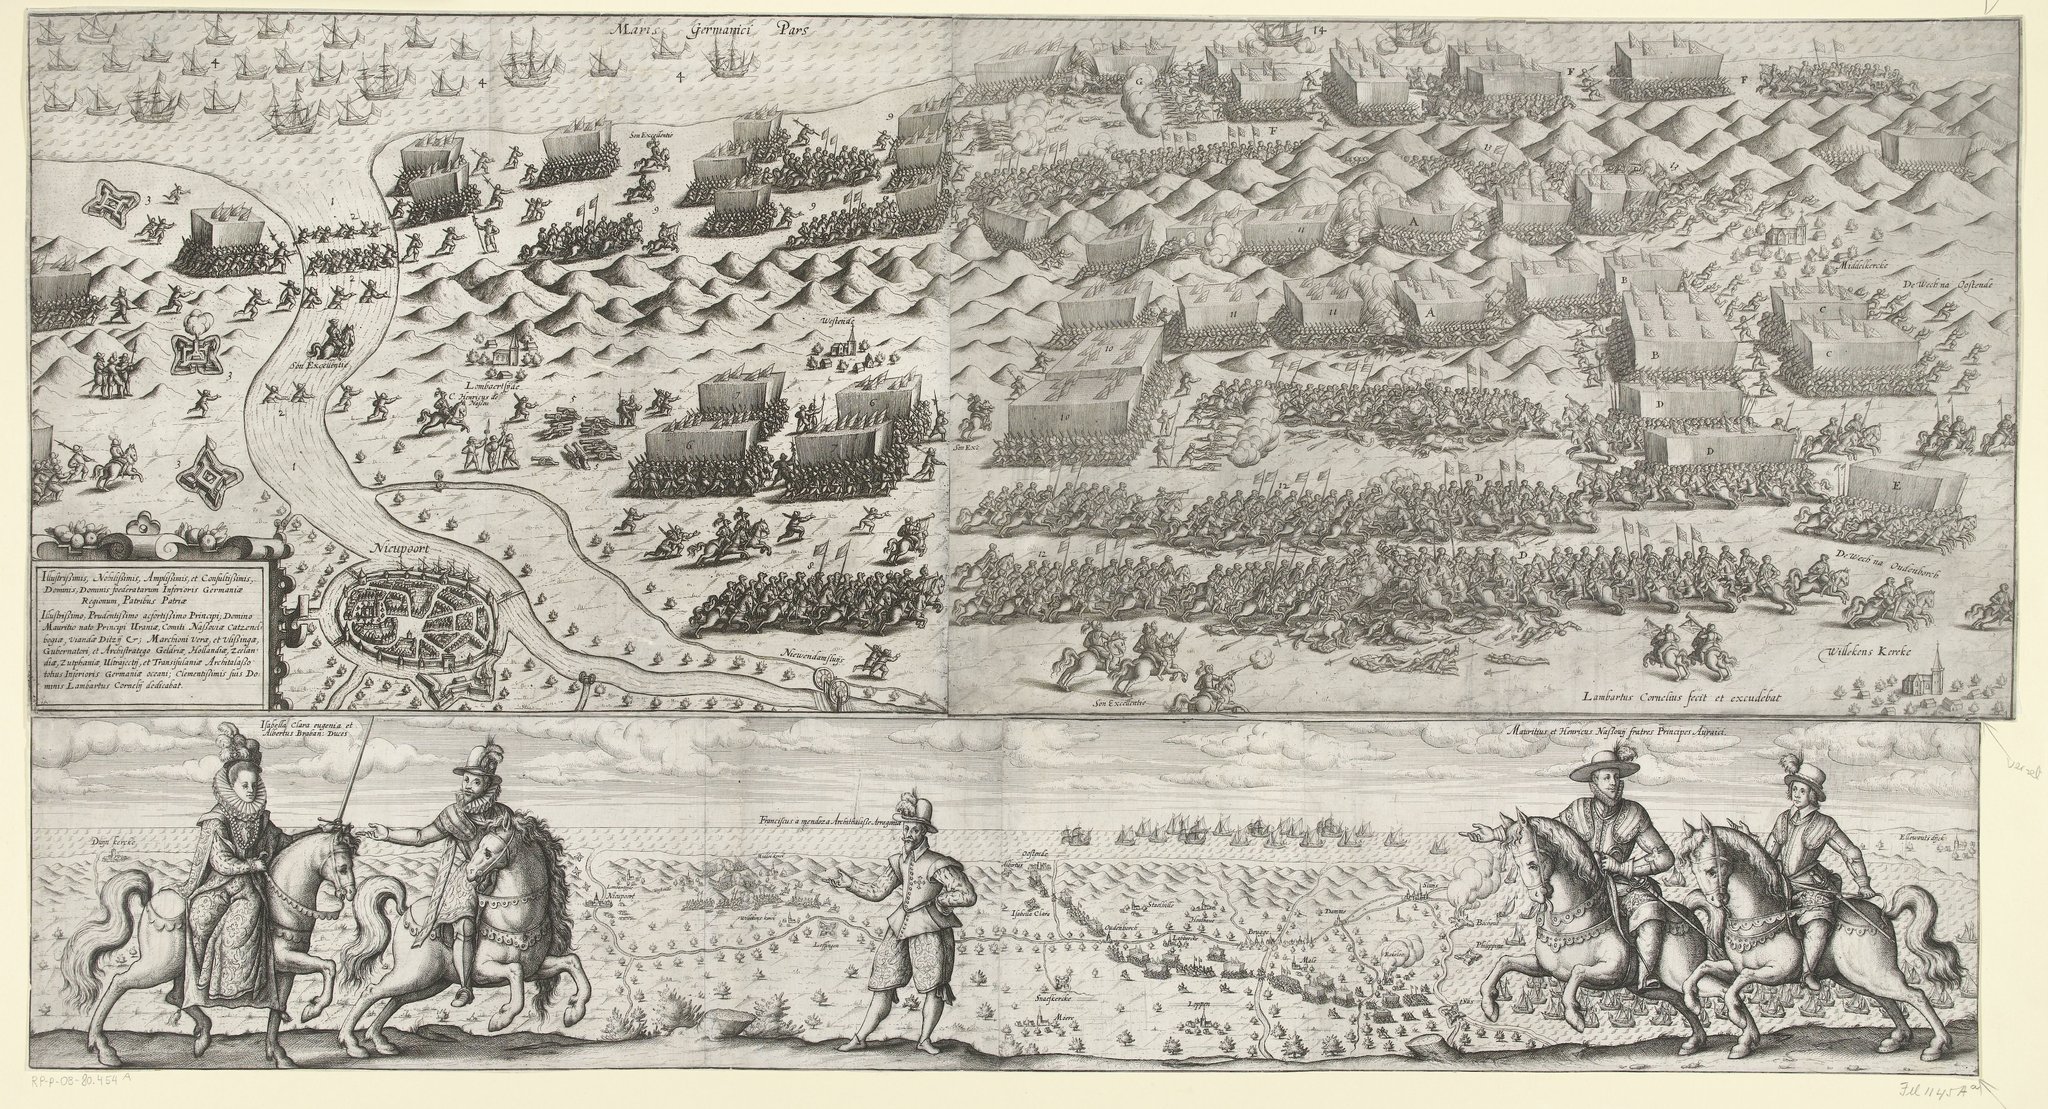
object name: print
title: De slag bij Nieuwpoort gecombineerd met portretten van Albrecht en Isabella met Mendoza en Maurits en Frederik Hendrik te paard voor het slagveld, 1600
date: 1600-1601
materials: paper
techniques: engraving, etching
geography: northern netherlands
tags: delft, frederick henry (prince of orange), the hague, maurice (prince of orange), infante van spanje isabella clara eugenia, brussels, albrecht aartshertog van oostenrijk, troop movements, transportation (+ sailing-ships), historical persons - bb - woman, historical persons, battle of nieuwpoort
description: De slag bij Nieuwpoort, 2 juli 1600. Grote voorstelling op twee bladen, links het Staatse leger onder Maurits, rechts de Spaanse troepen onder Albrecht. Linksonder een cartouche met de opdracht in het Latijn. Hieronder vastgeplakt links Albrecht en Isabella te paard met de Spaanse legeraanvoerder Mendoza staand en rechts prins Maurits en Frederik Hendrik te paard voor het slagveld, in vier bladen. Bij deze prent behoort een los tekstblad in het Duits.